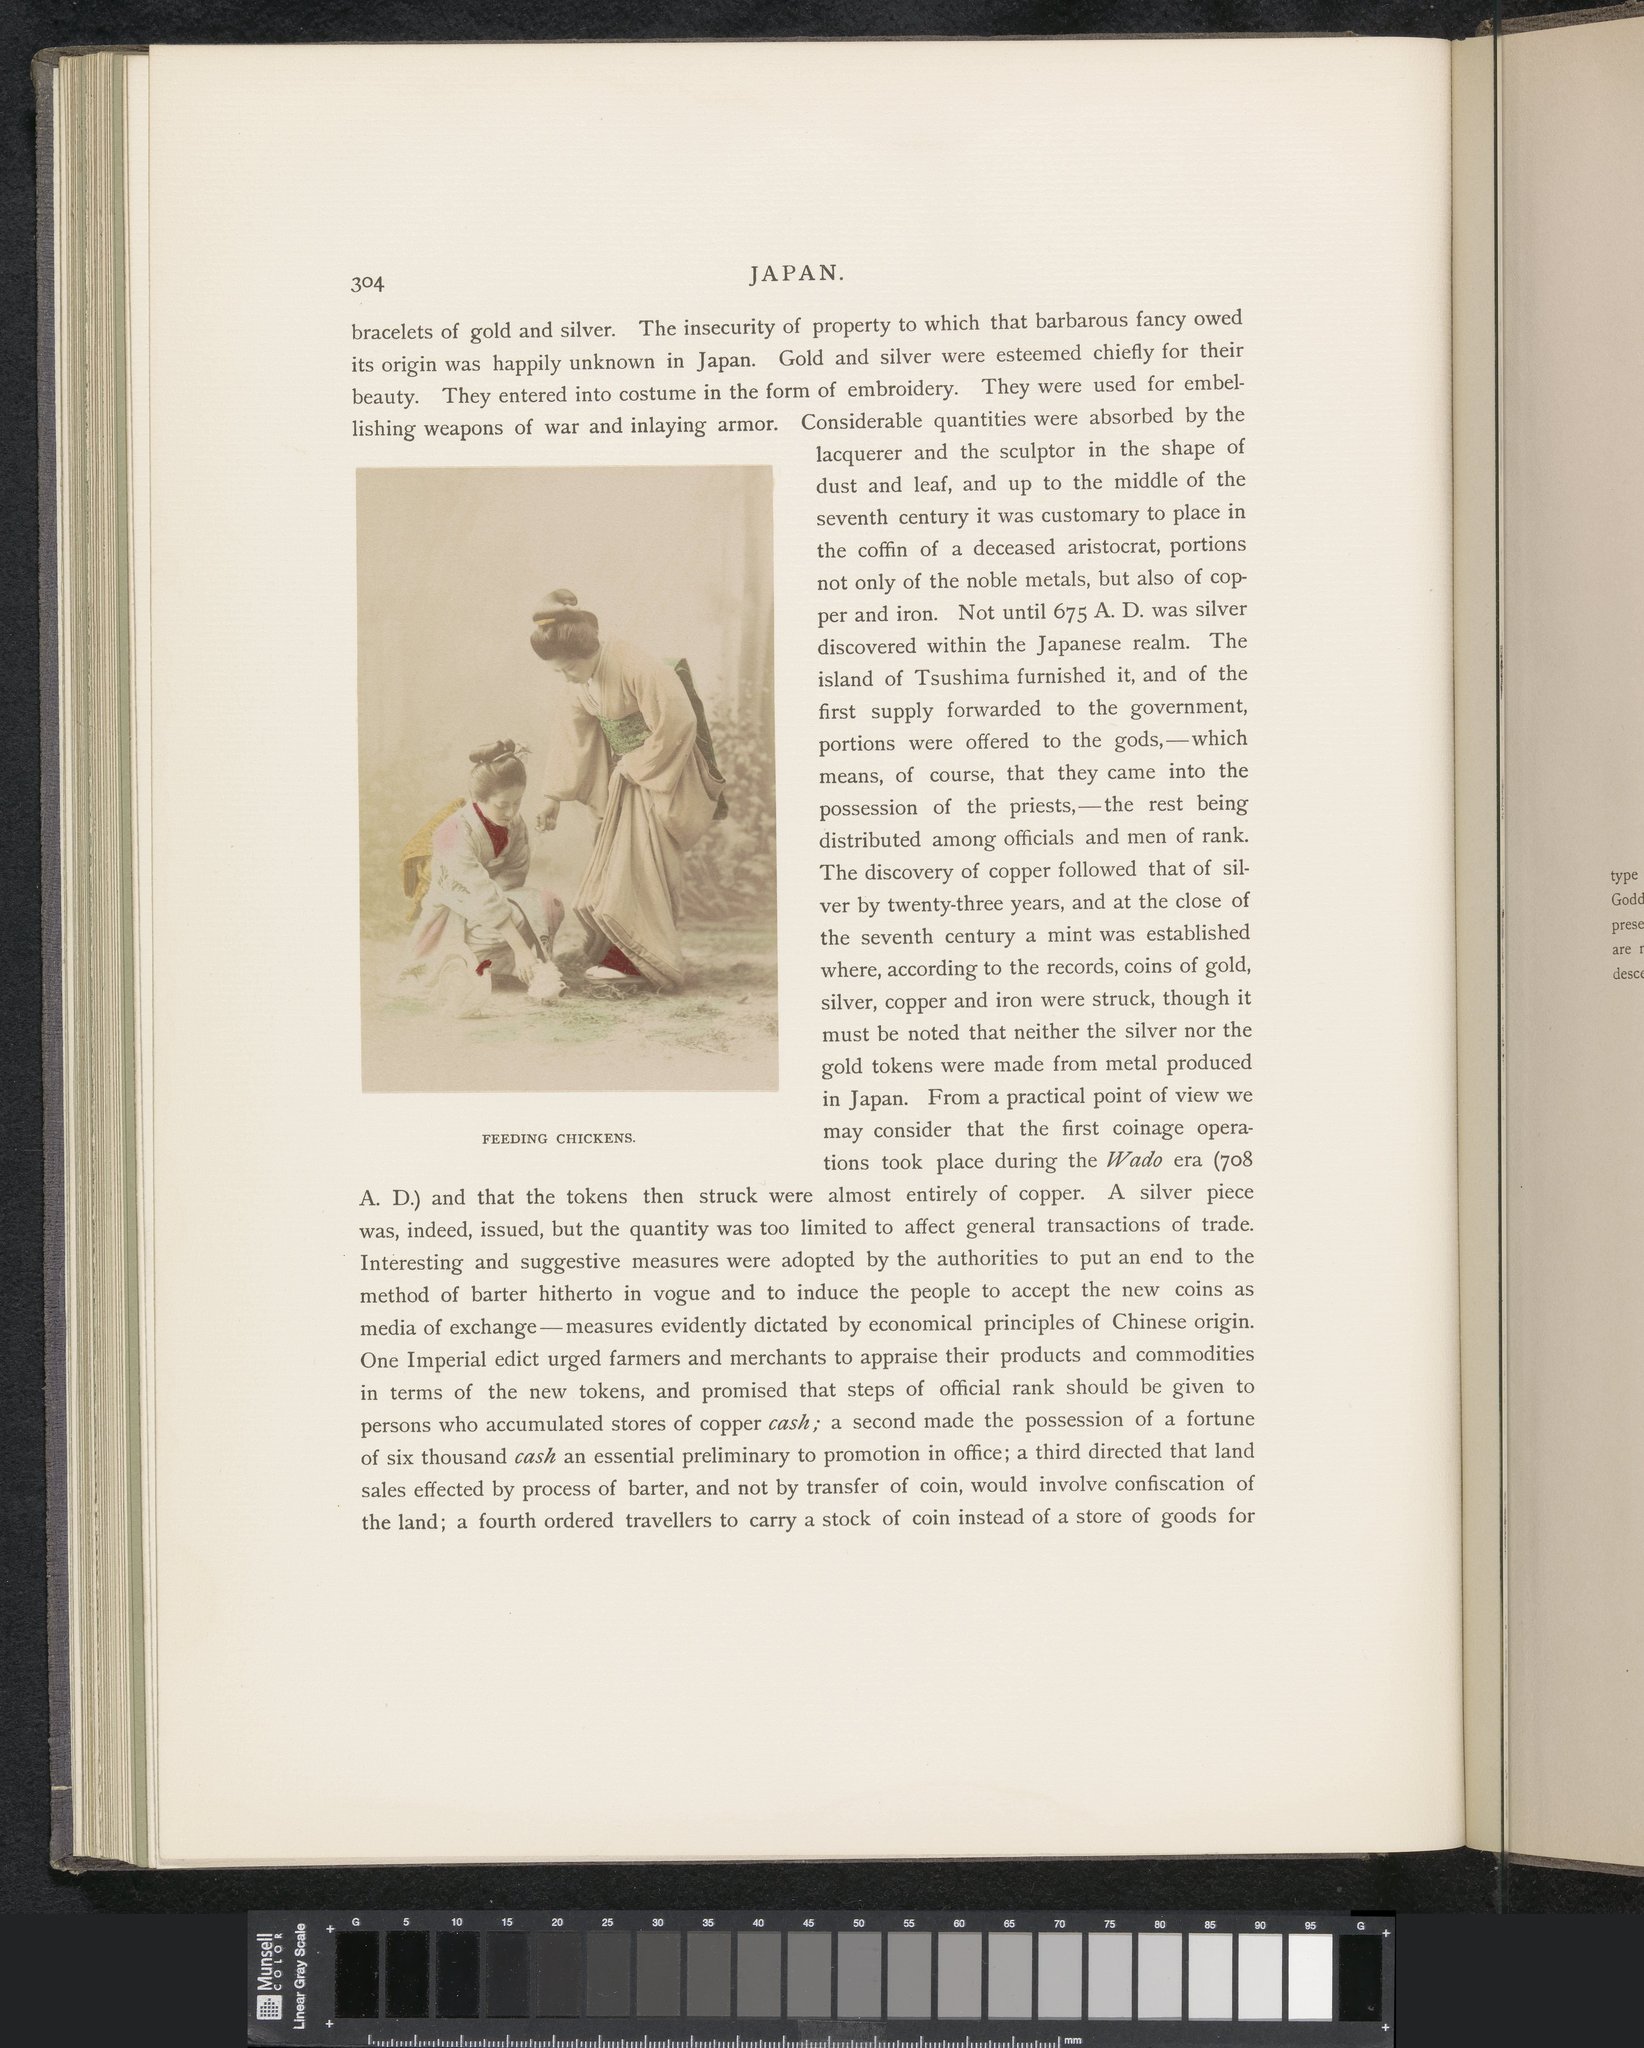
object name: page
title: Feeding chickens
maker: Anonymous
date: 1887-1897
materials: photographic support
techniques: albumen print, hand coloring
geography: japan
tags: fowl (cock, hen, chicken, etc.), feeding wild animals